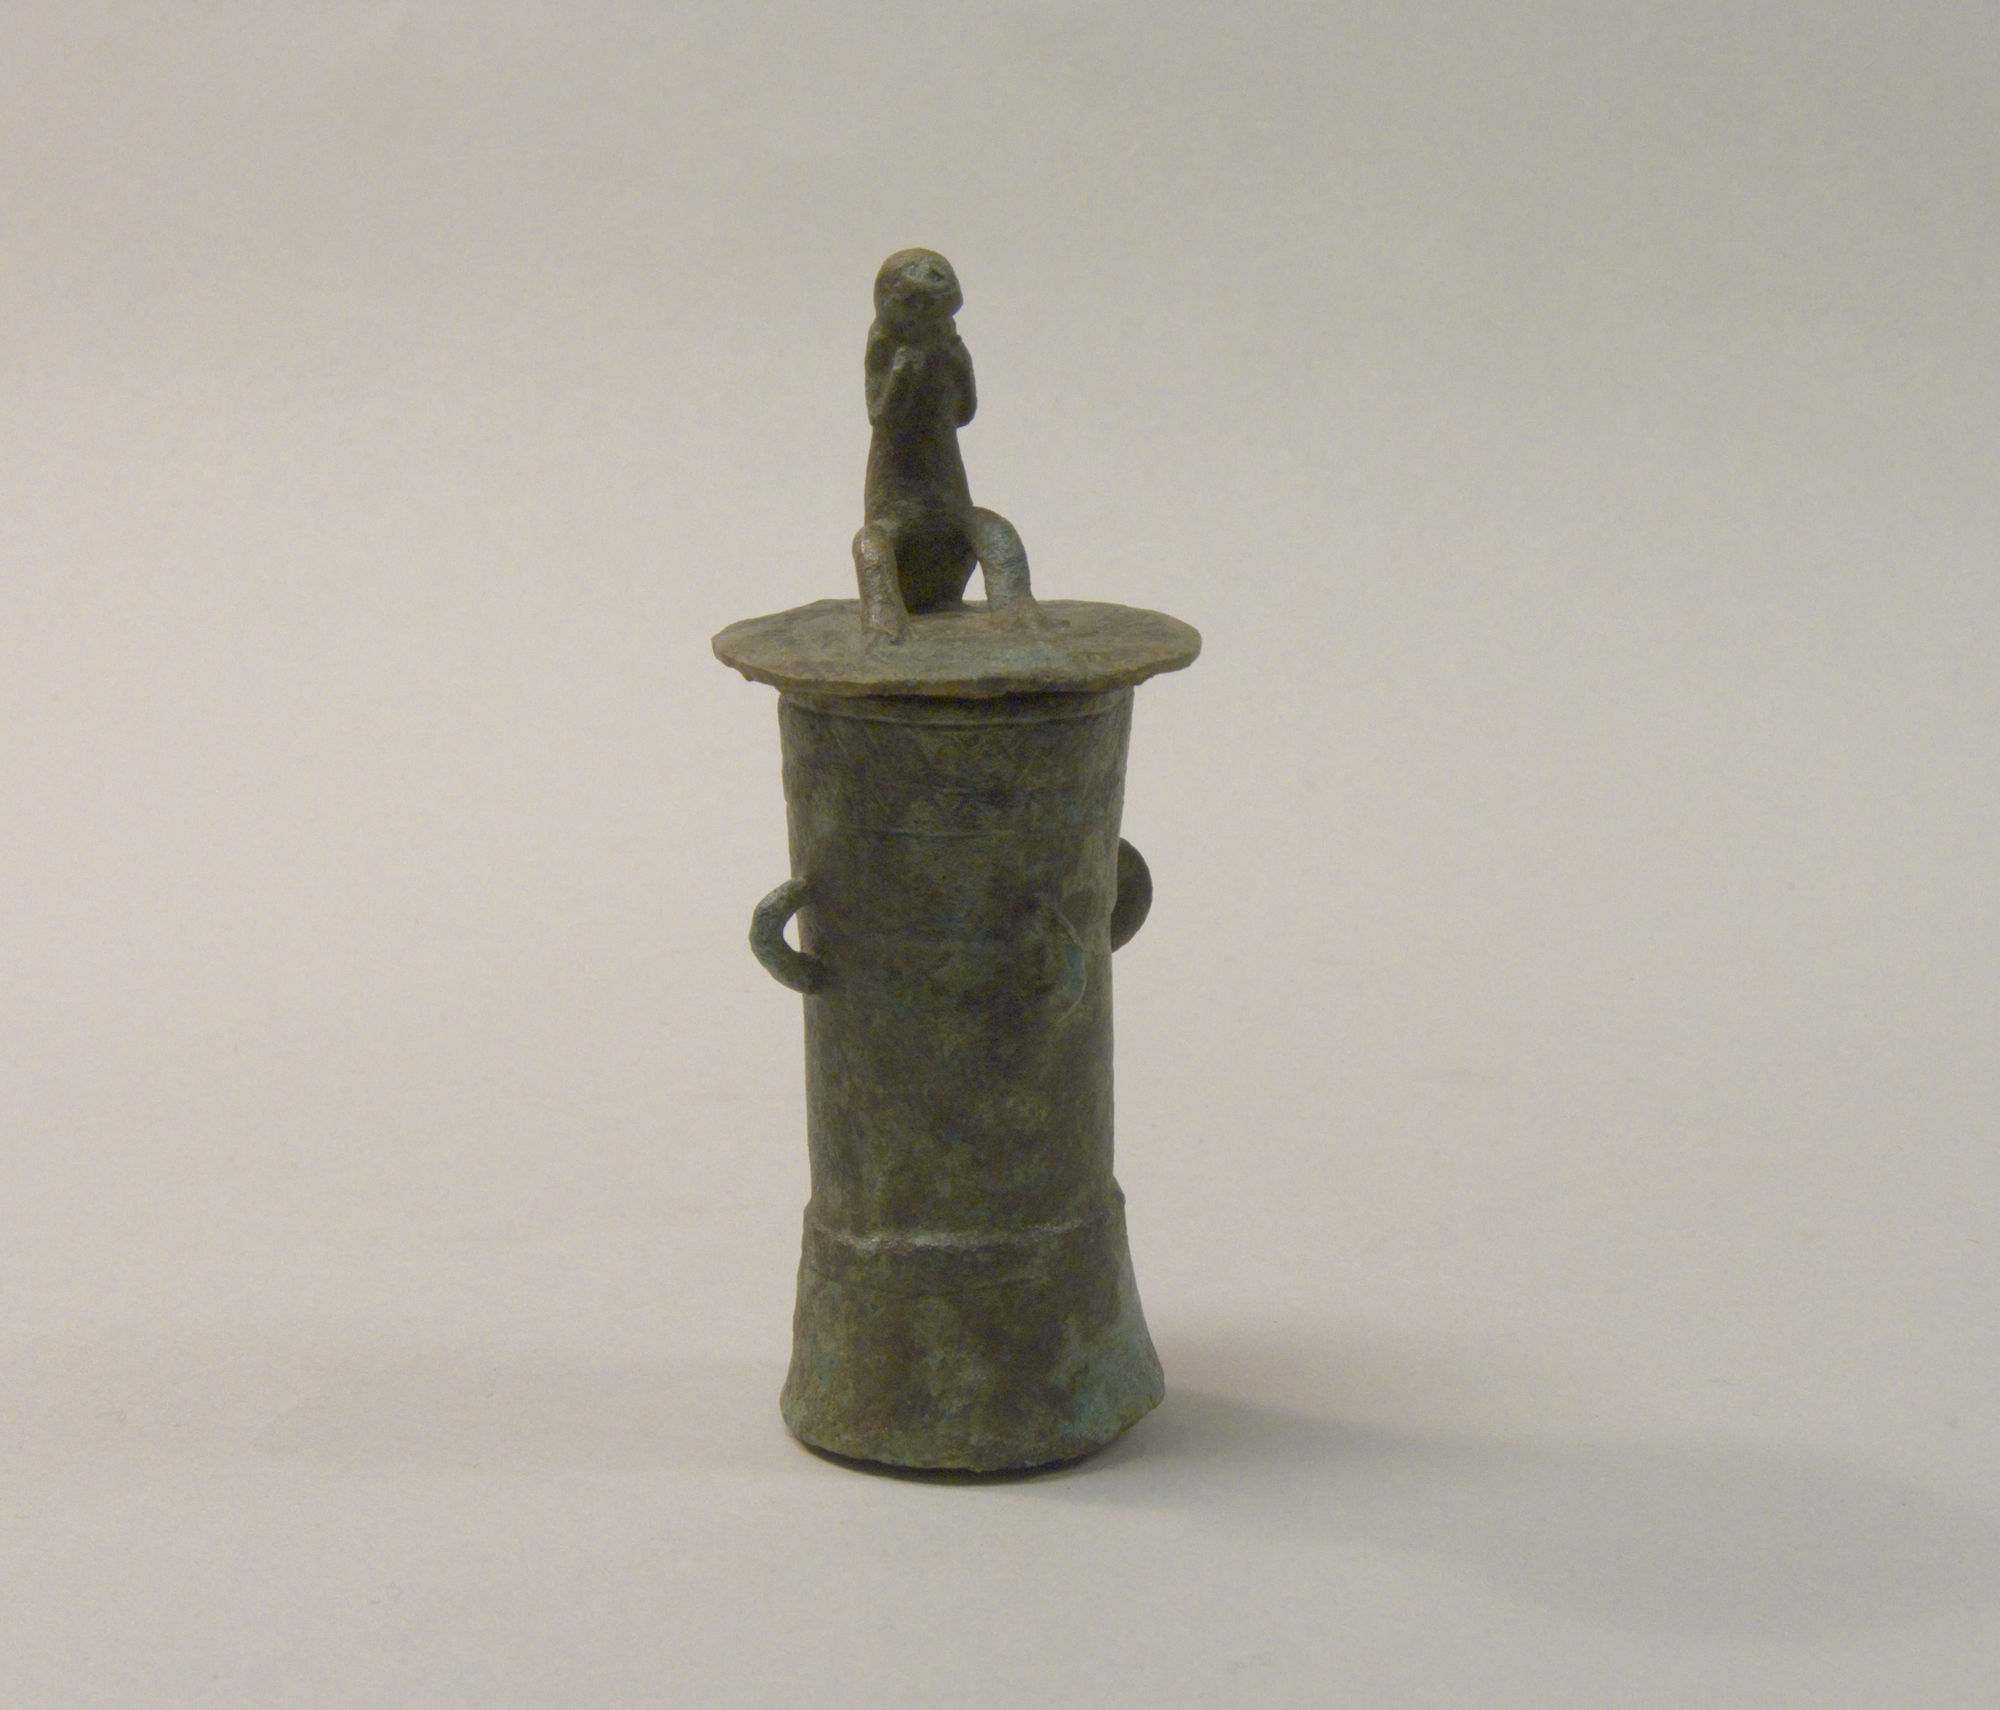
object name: lime container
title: Lime Container in the Form of a "Mloko" Drum Surmounted by a Crouching Figure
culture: indonesian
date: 500 BCE-300 CE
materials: bronze